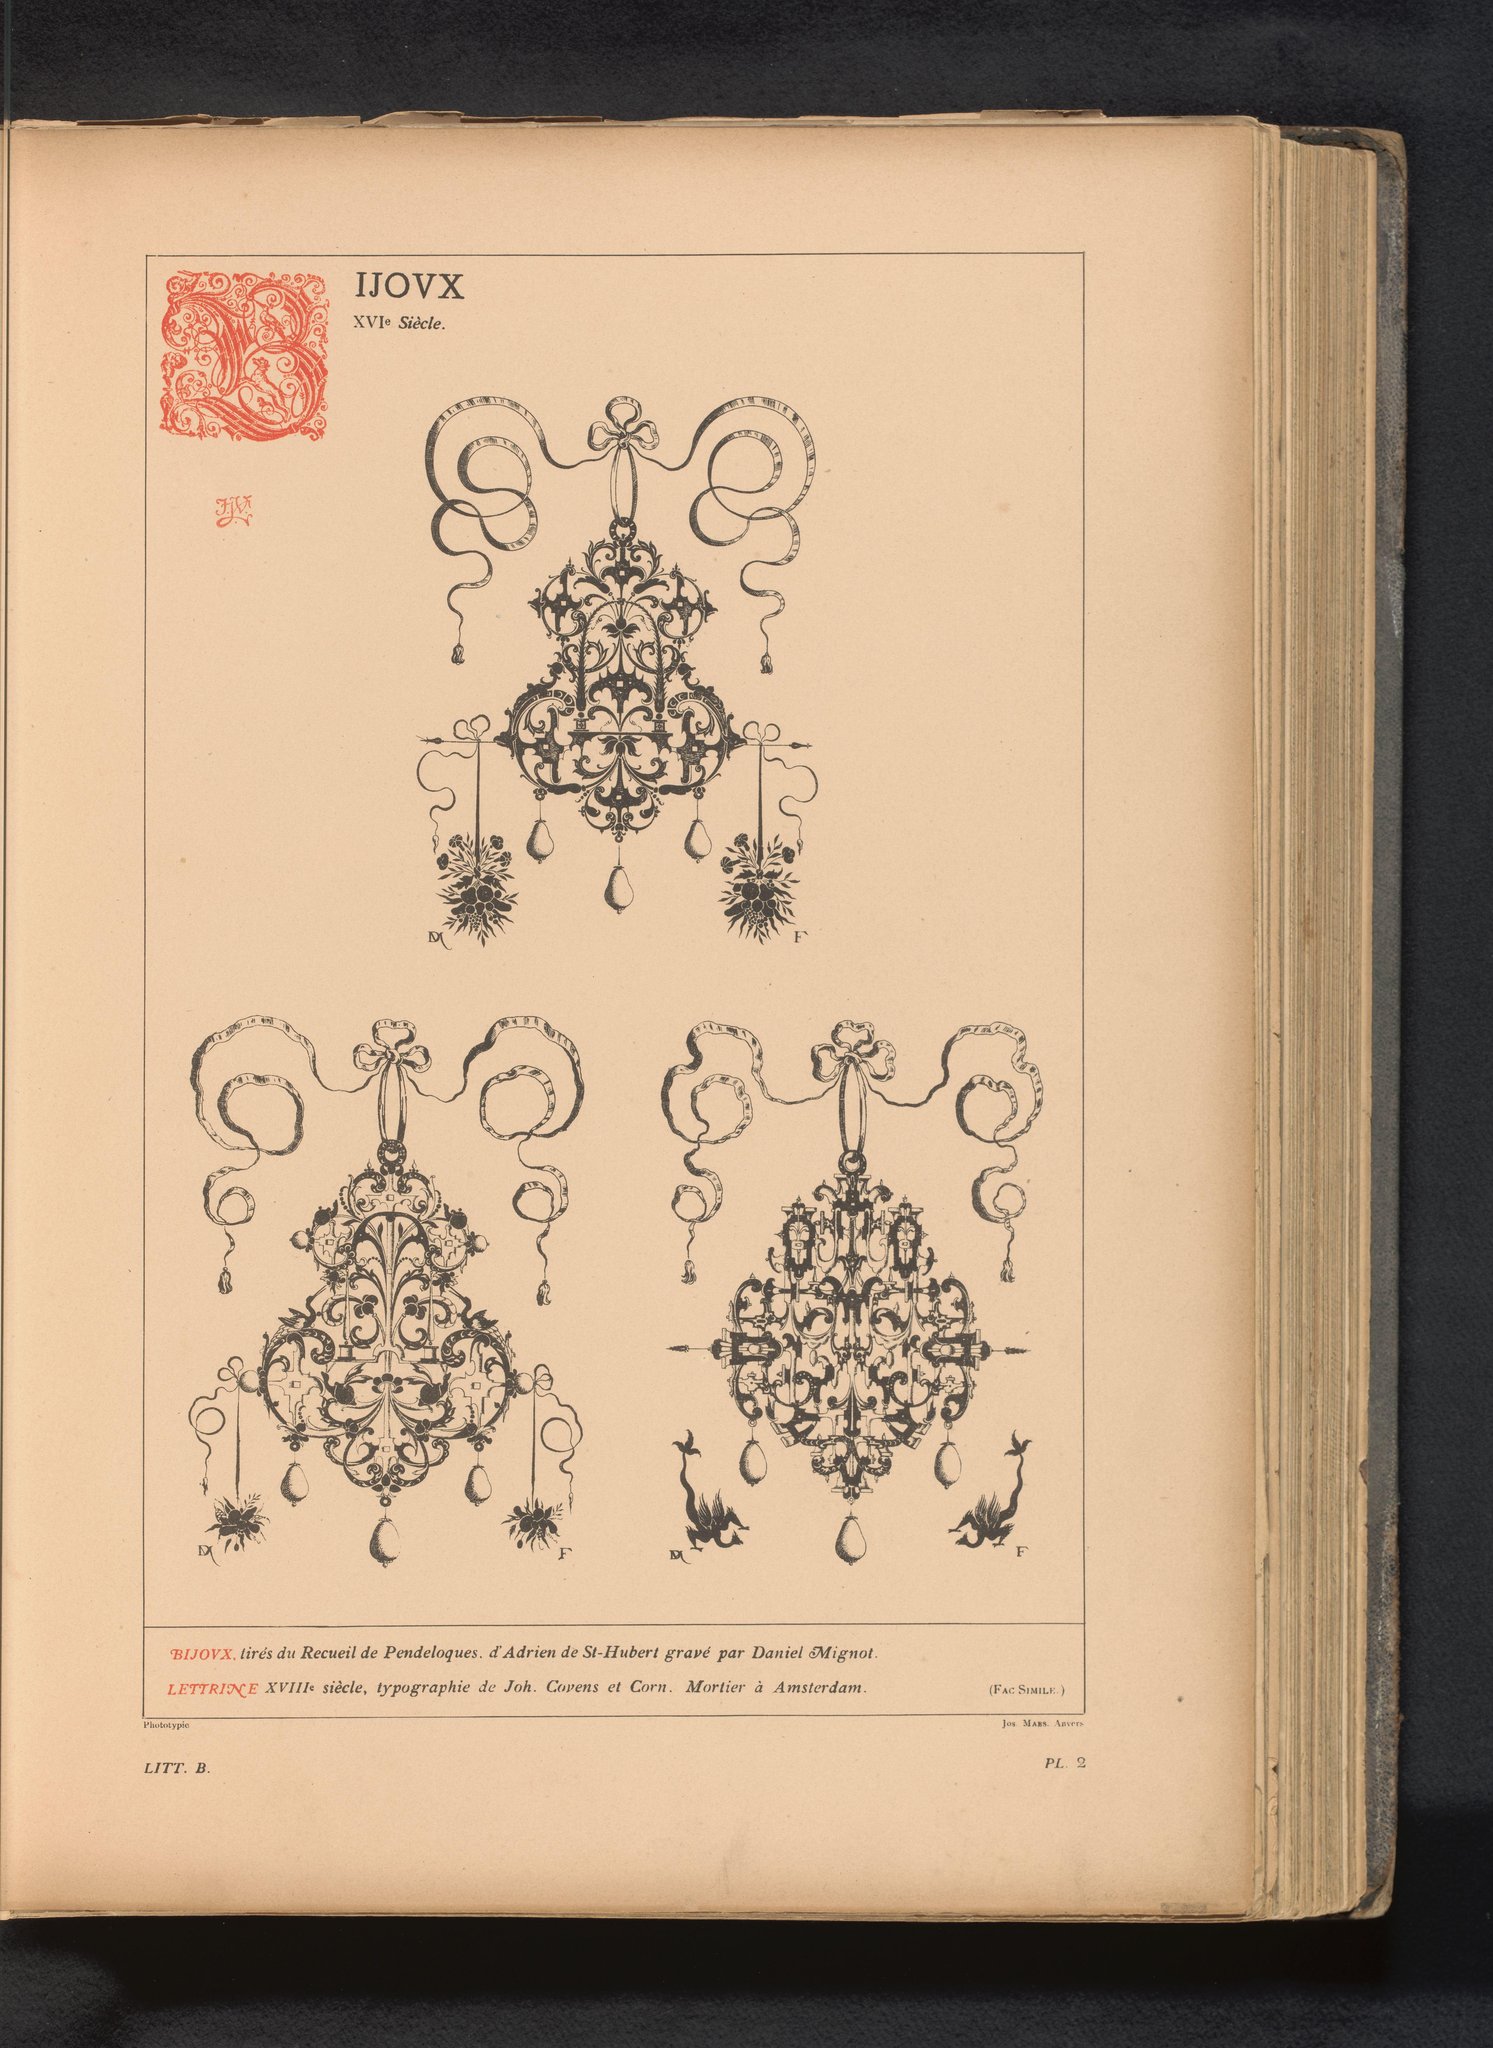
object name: photomechanical print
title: Bijoux, XVIe Siècle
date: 1875-1880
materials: paper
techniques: photolithography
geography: antwerp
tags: ornaments, jewels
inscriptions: inscription: ‘Bijoux, tirés du (...)’, inscription: ‘LITT: B. - PL. 2.’, monogram: ‘JJvY’